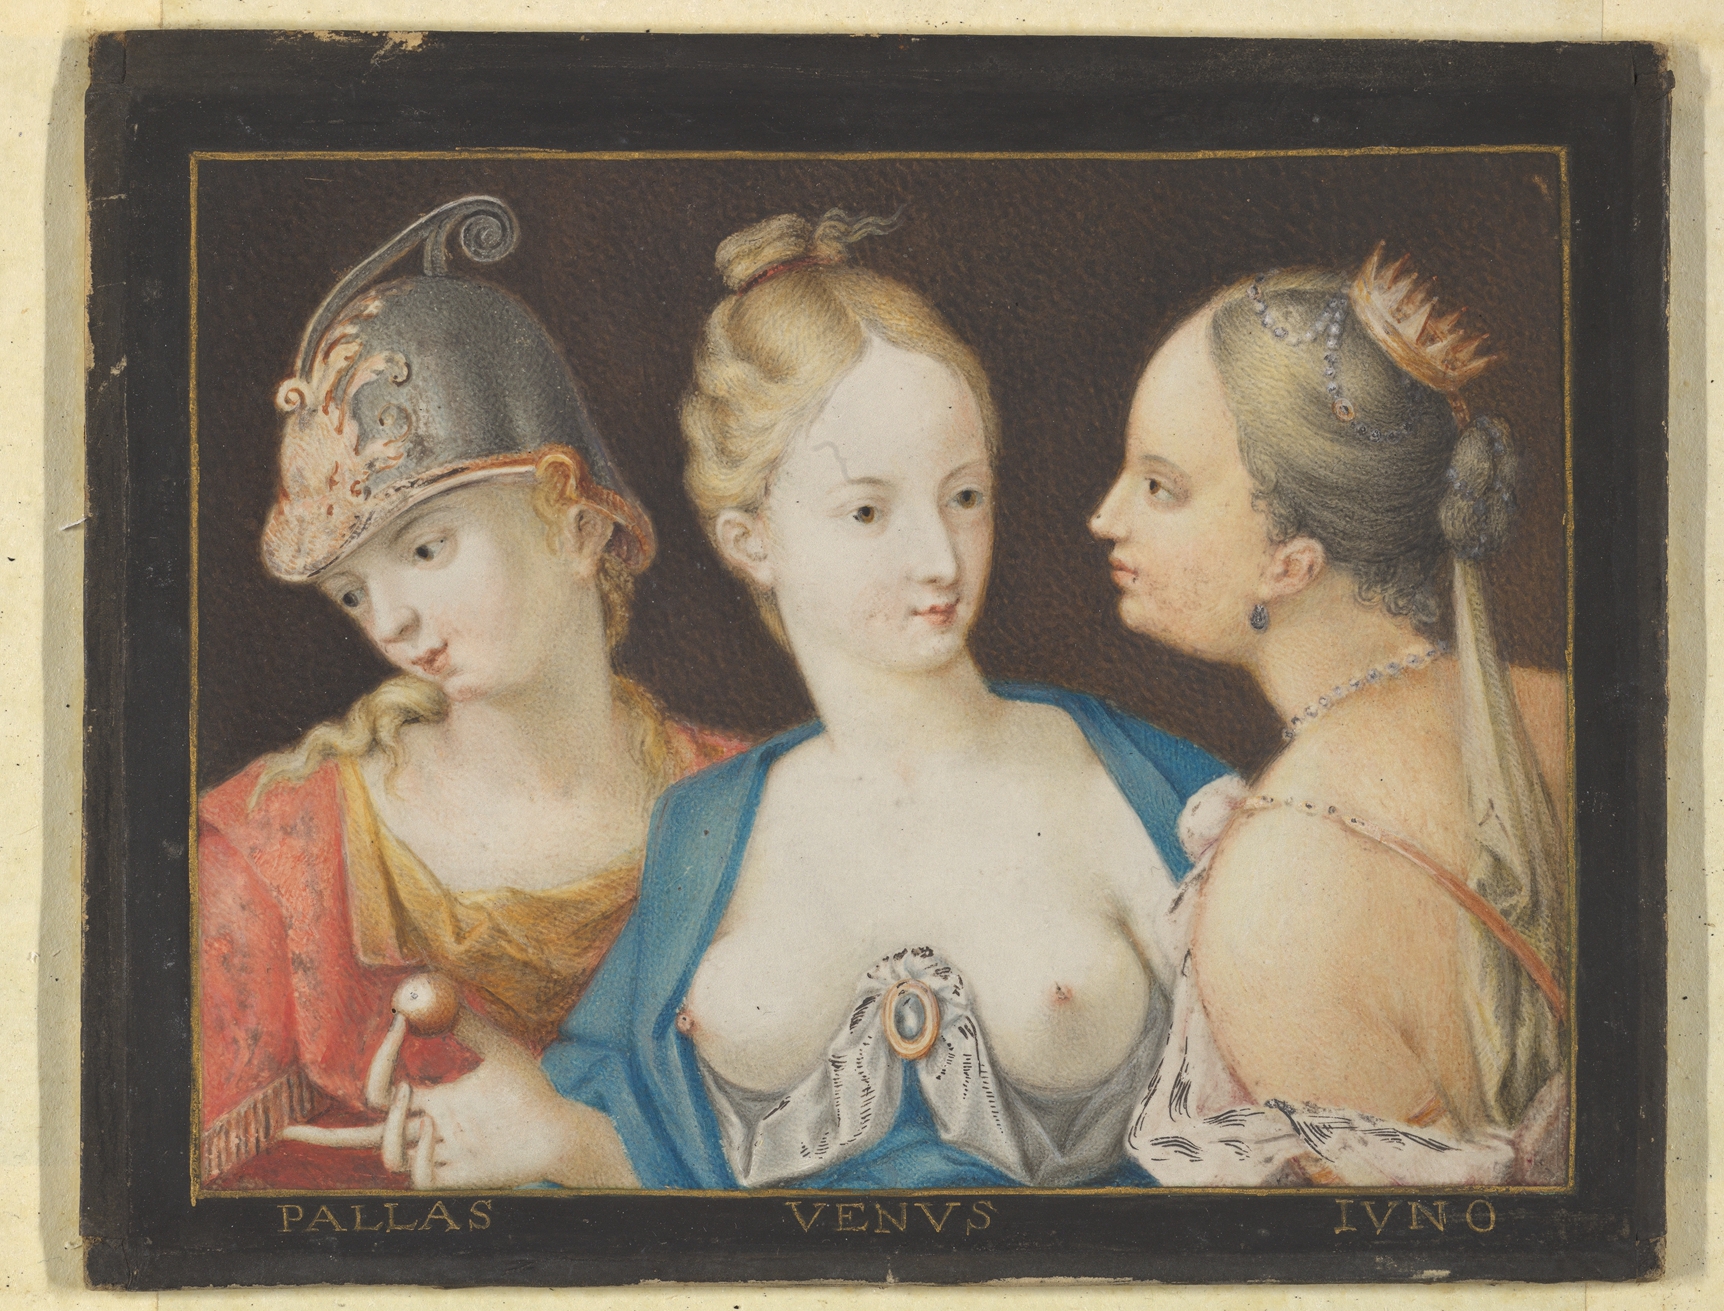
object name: drawing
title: Heads of Goddesses (Pallas, Venus, Juno)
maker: anonymous, french, 17th century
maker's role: artist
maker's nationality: french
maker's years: 1600-1700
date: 1600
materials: gold, gouache, ink, watercolor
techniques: pen, wash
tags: juno,venus,goddess